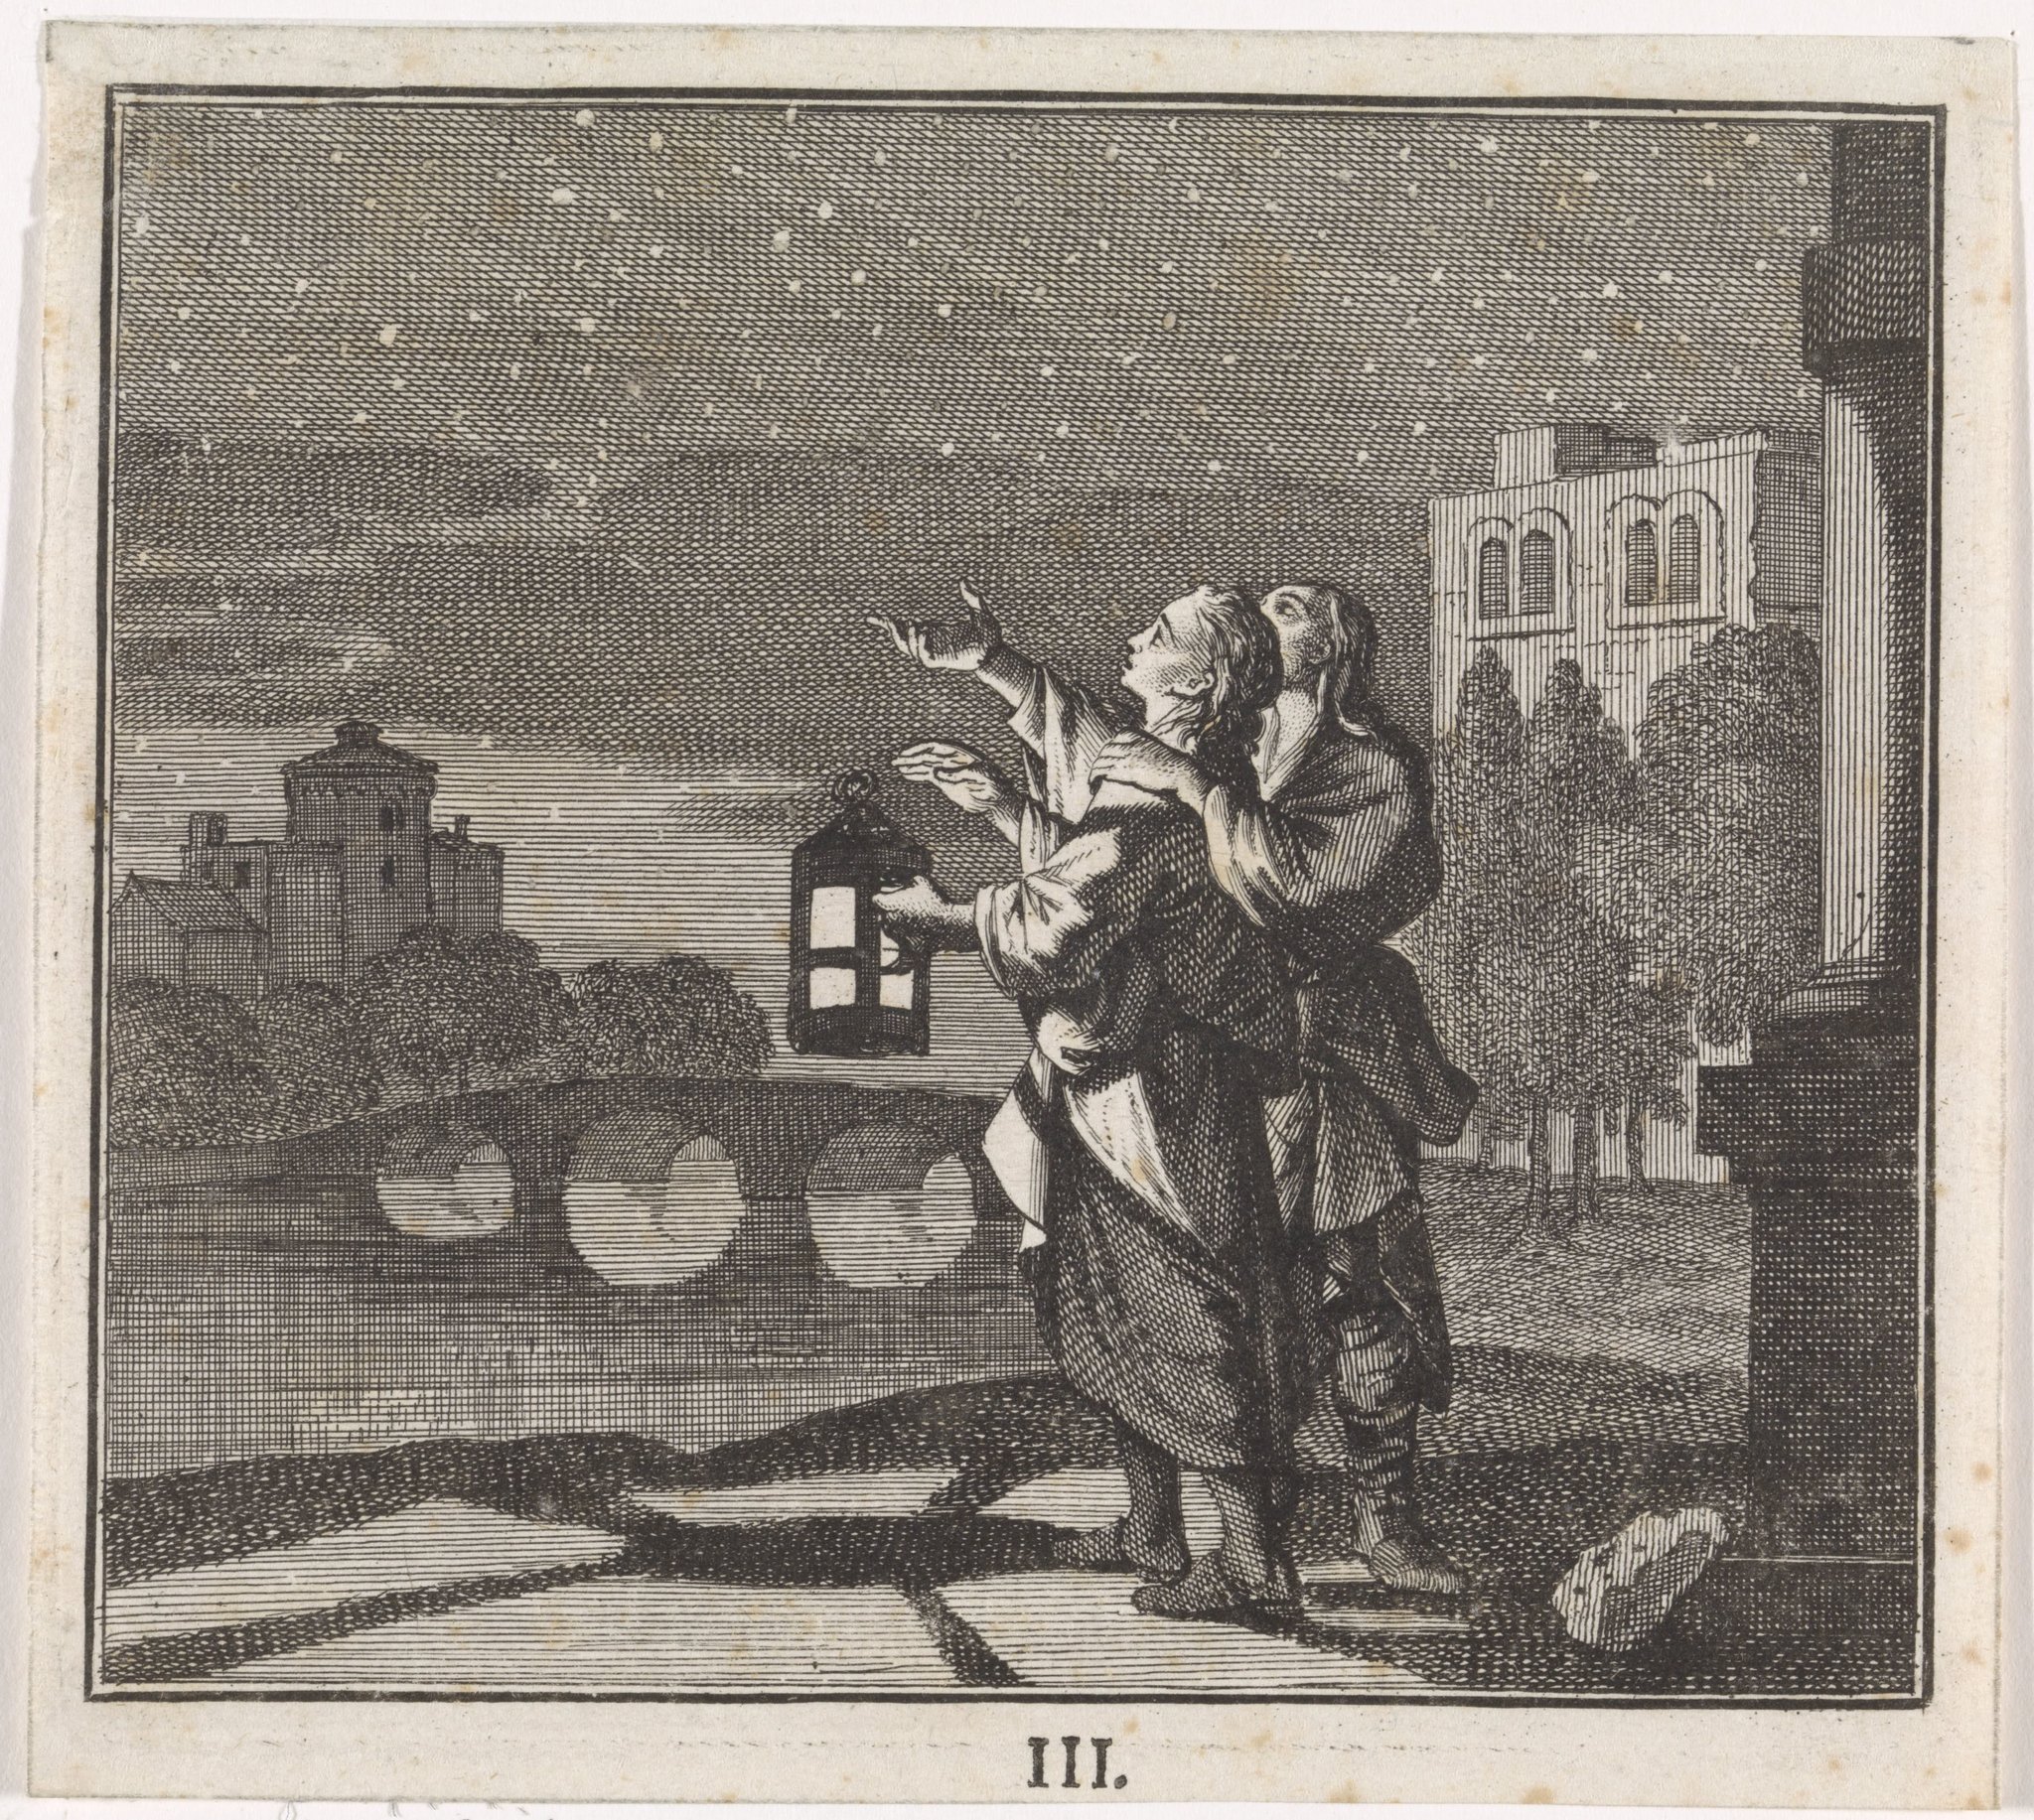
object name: print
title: Twee personen bestuderen de sterrenhemel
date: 1700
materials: paper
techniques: etching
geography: nuremberg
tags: river, lantern, stars, abstract ideas and concepts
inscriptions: collector's mark: Lugt 2228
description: Boekillustratie voor Weigel, Christoph. Ethica Naturalis seu Documenta Moralia e Variis rerum Naturalium proprietatibus Virtutum Vitiorumq symbolicis imaginibus collecta. Neurenberg: Christoph Weigel: c. 1700.